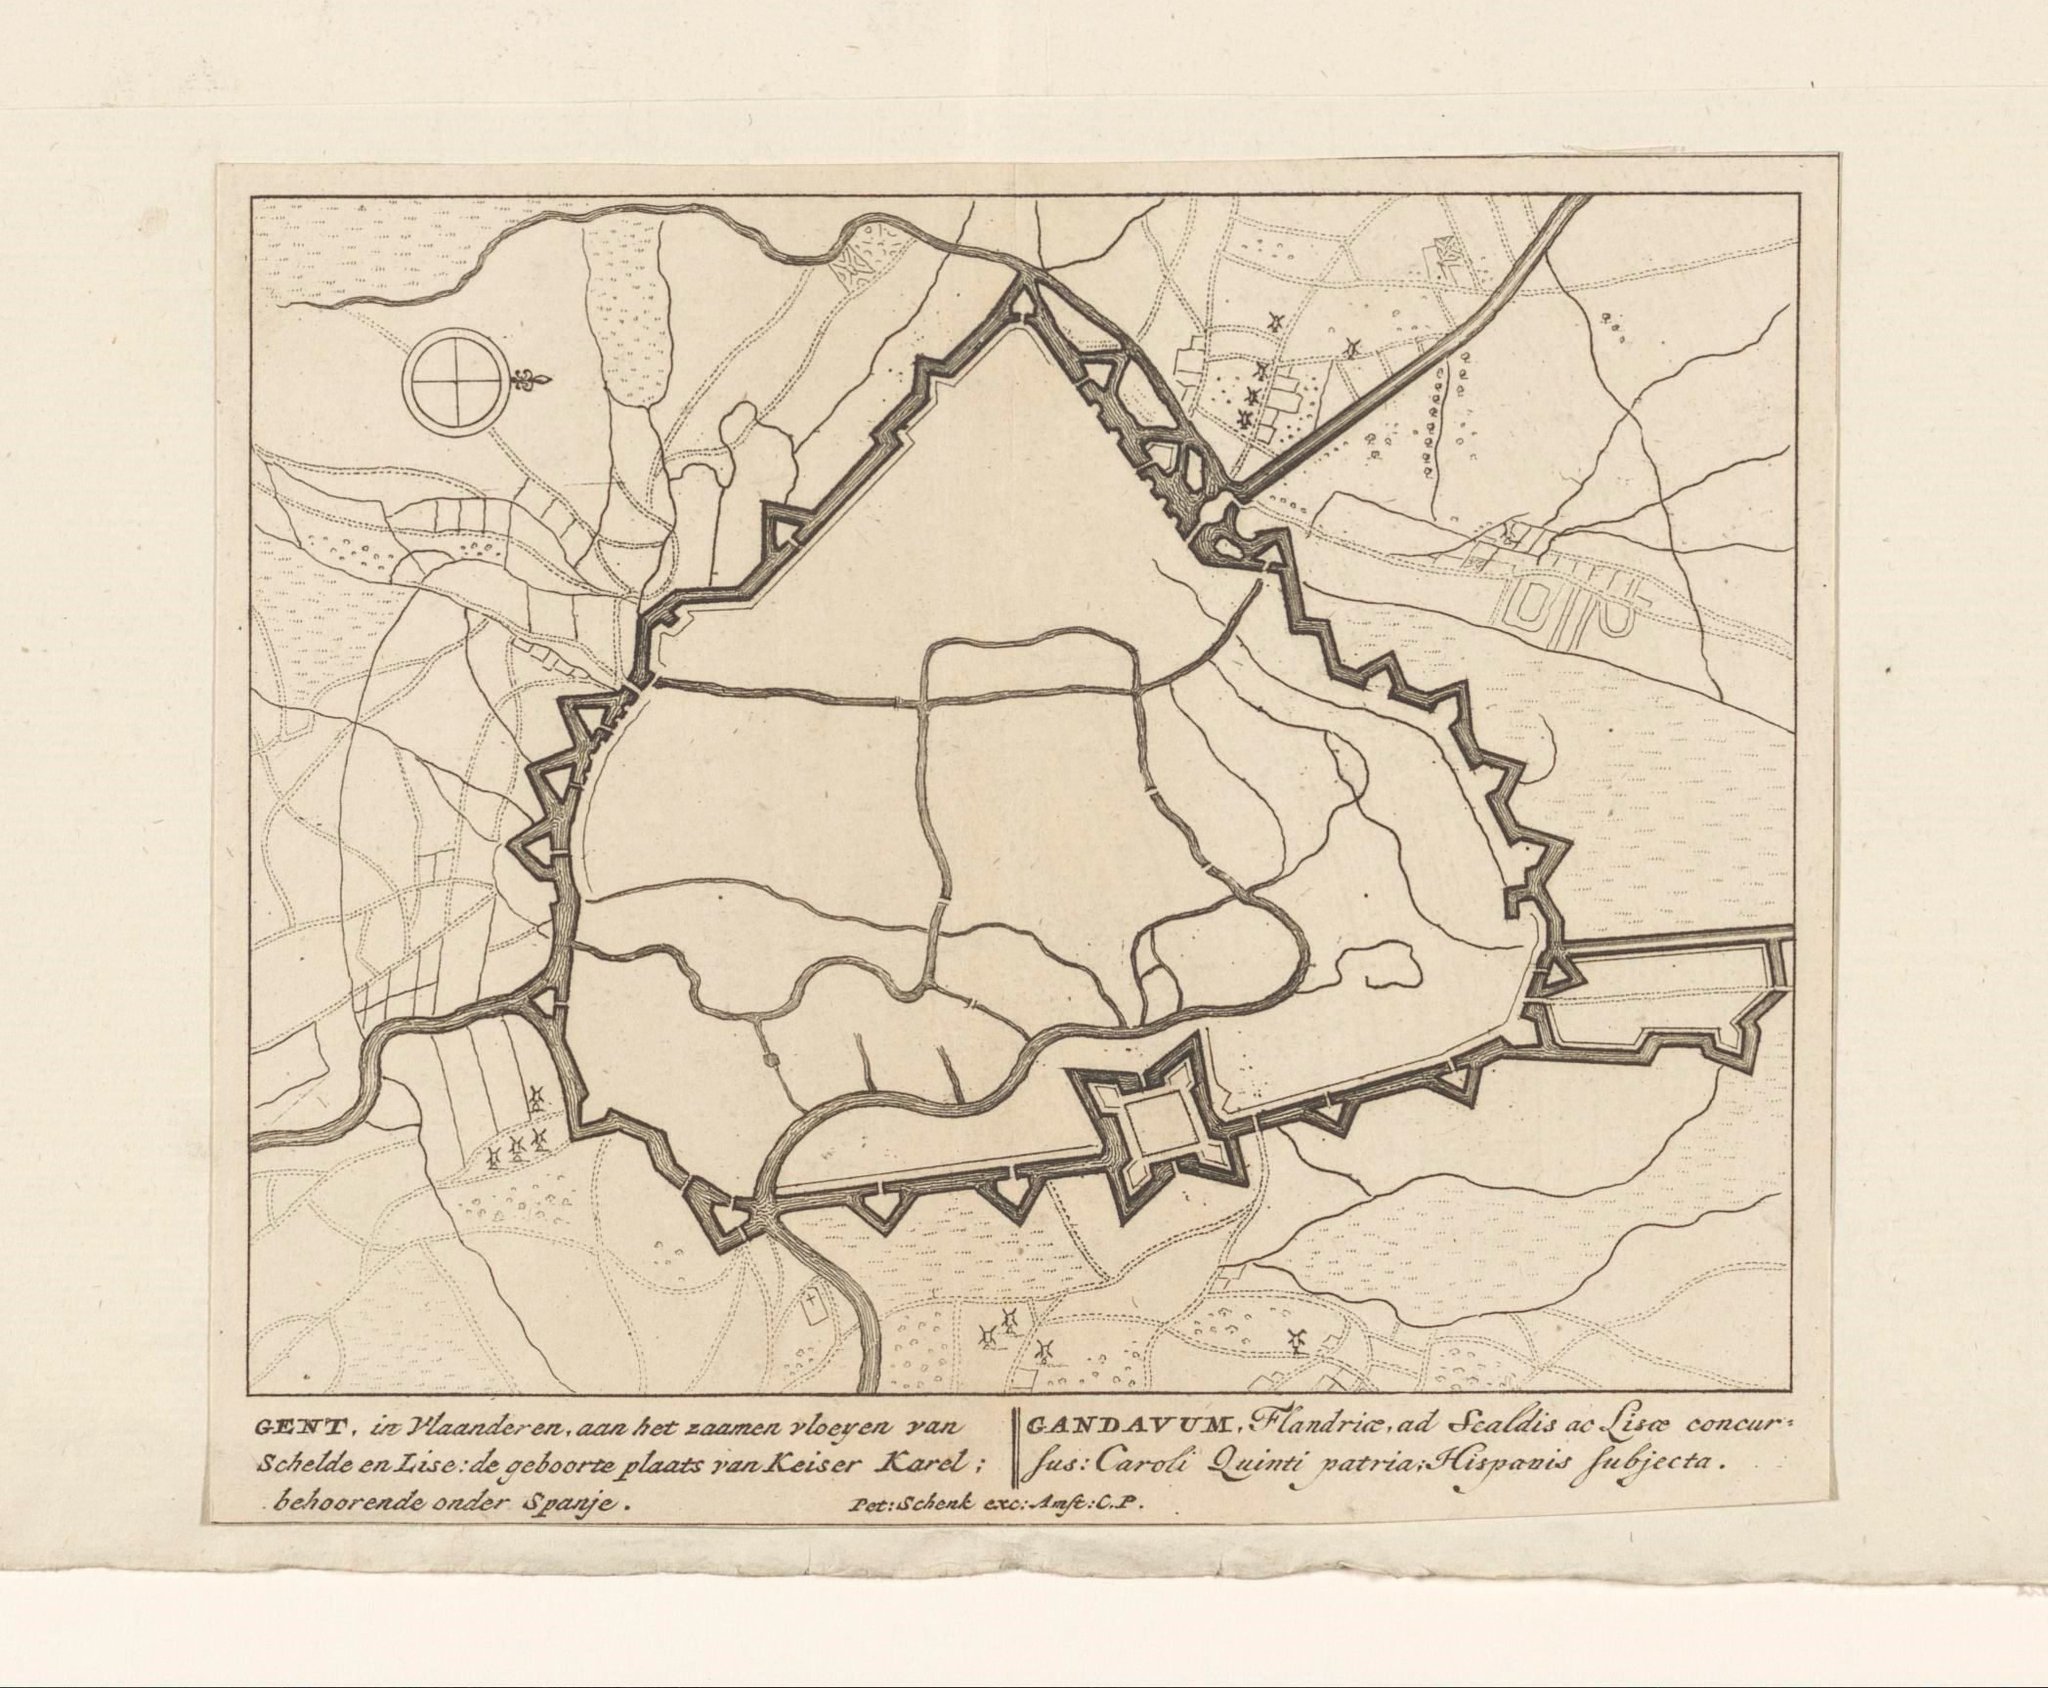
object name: area plan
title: Gent, in Vlaanderen, aan het zaamen vloeyen van Schelde en Lise (...) / Gandavum, Flandriae, ad Scaldis ac Lisoe concursus (...)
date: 1695-1711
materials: paper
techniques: engraving, etching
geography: amsterdam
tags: fortified city, maps of cities, ghent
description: Vestingplattegrond van Gent. Onder de voorstelling onderschriften in het Nederlands en Latijn.